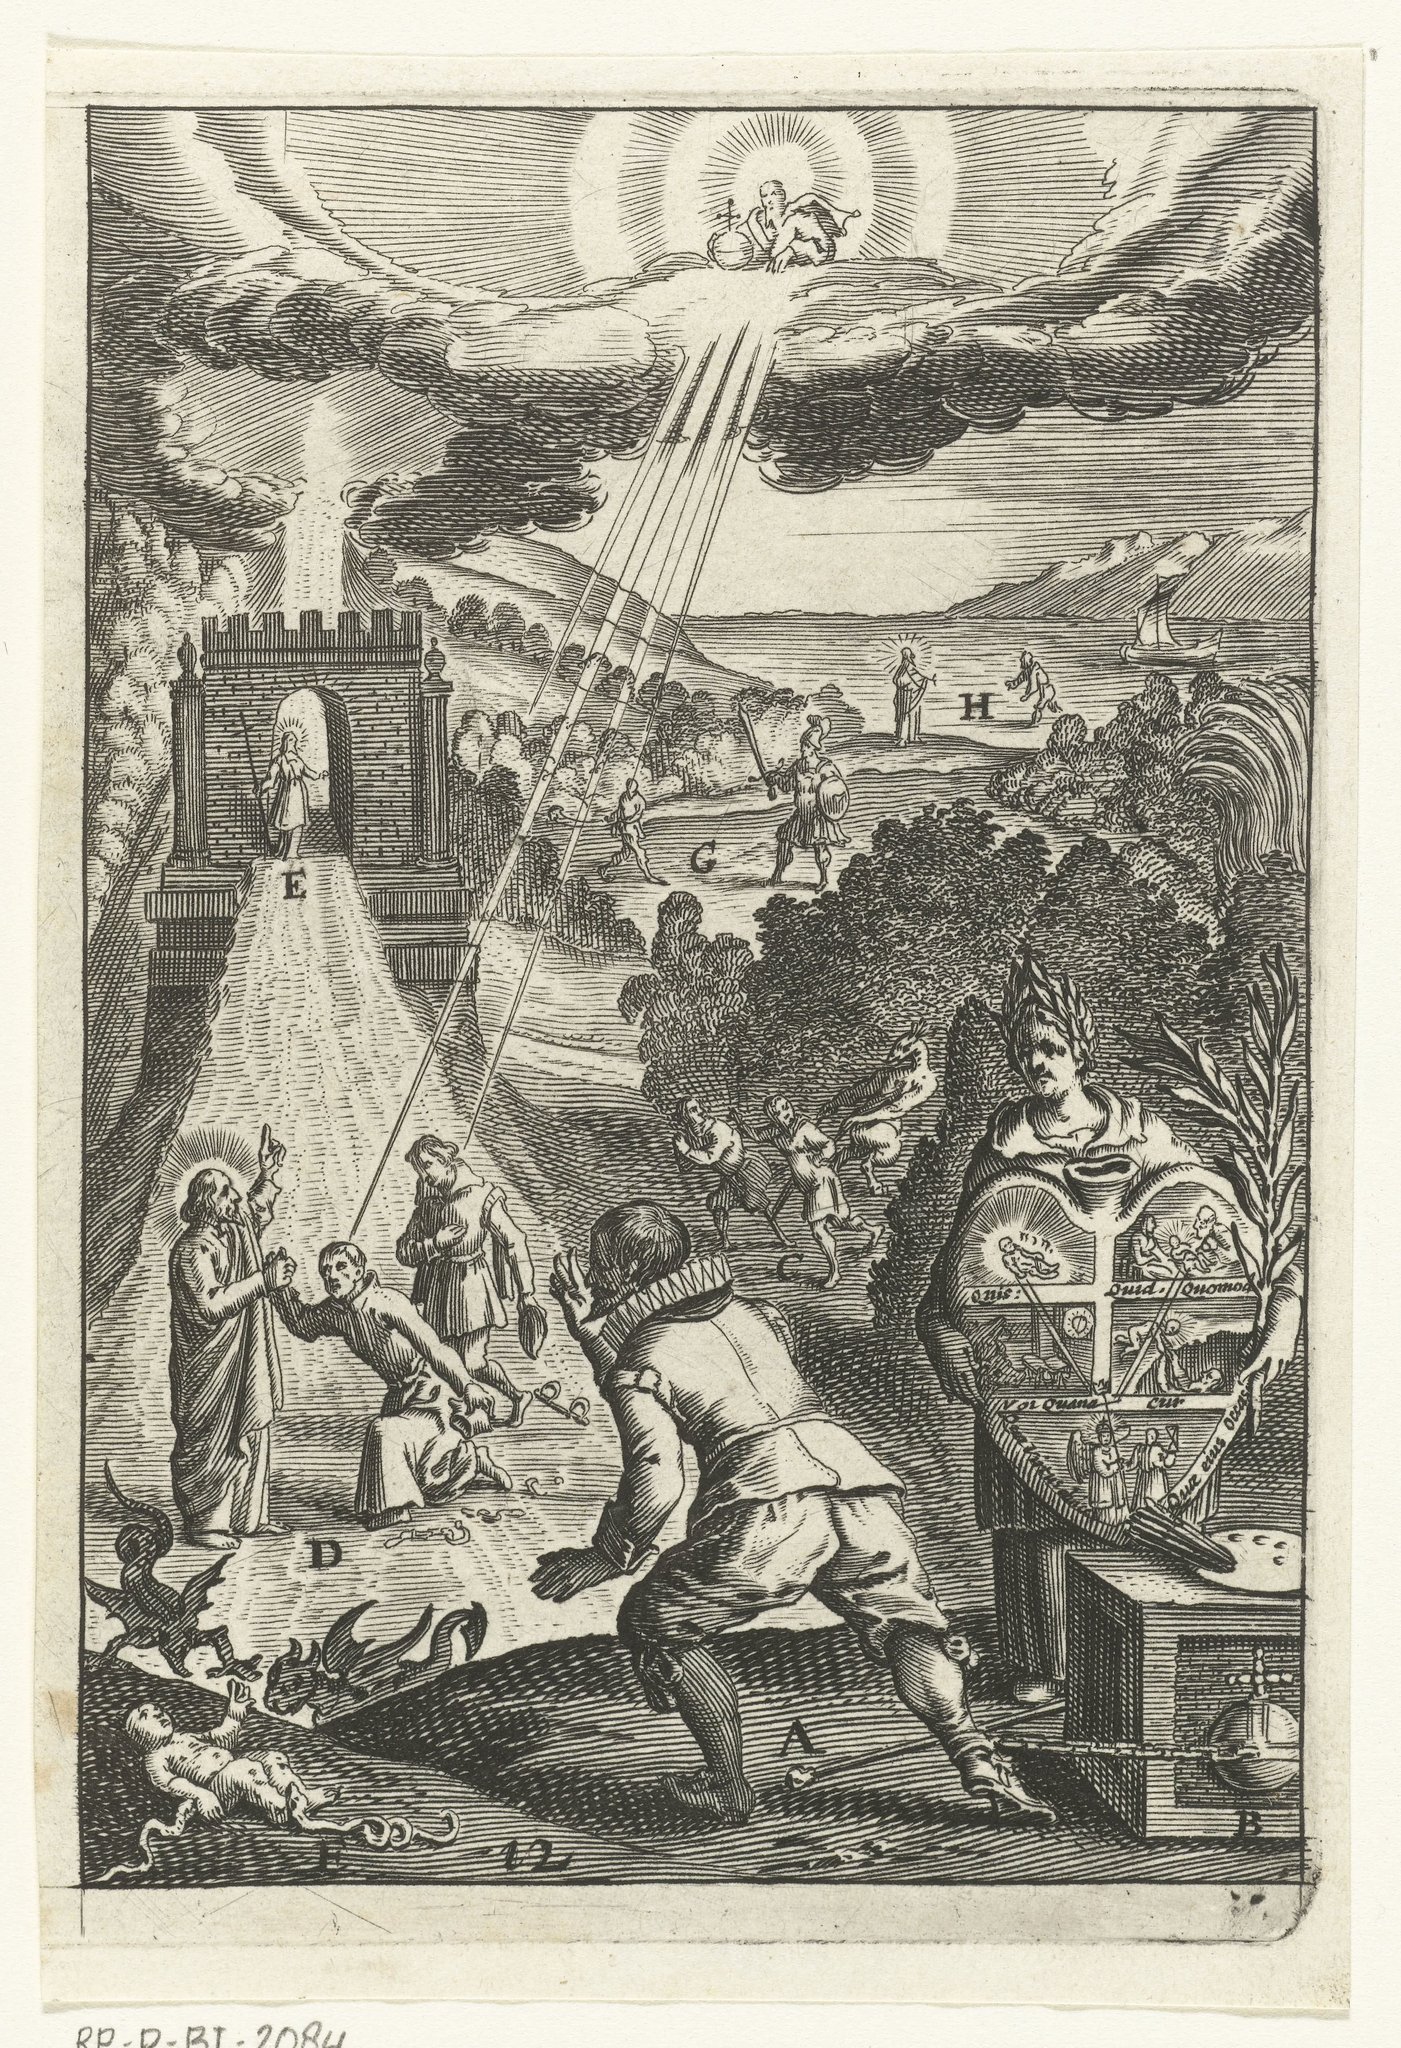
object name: book illustration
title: Embleem met man die ziet hoe vertrouwen in God een mens kan verlossen van zonden en doen leven in deugd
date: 1620-1649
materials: paper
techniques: engraving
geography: antwerp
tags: the life of man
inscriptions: collector's mark: Lugt 2228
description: Een geketende man kijkt naar een tafereel waarbij Christus twee gelovige mannen verlost van hun zonden en hun ketenen. Hun vertrouwen in God doet hen leven in deugd en stuurt hen op de juiste weg naar het eeuwige leven die op de achtergrond is weergegeven. Als voorbeeld wordt een bijbelscène aangehaald: de herdersjongen David won de strijd tegen de grote Goliath door zijn standvastige geloof.